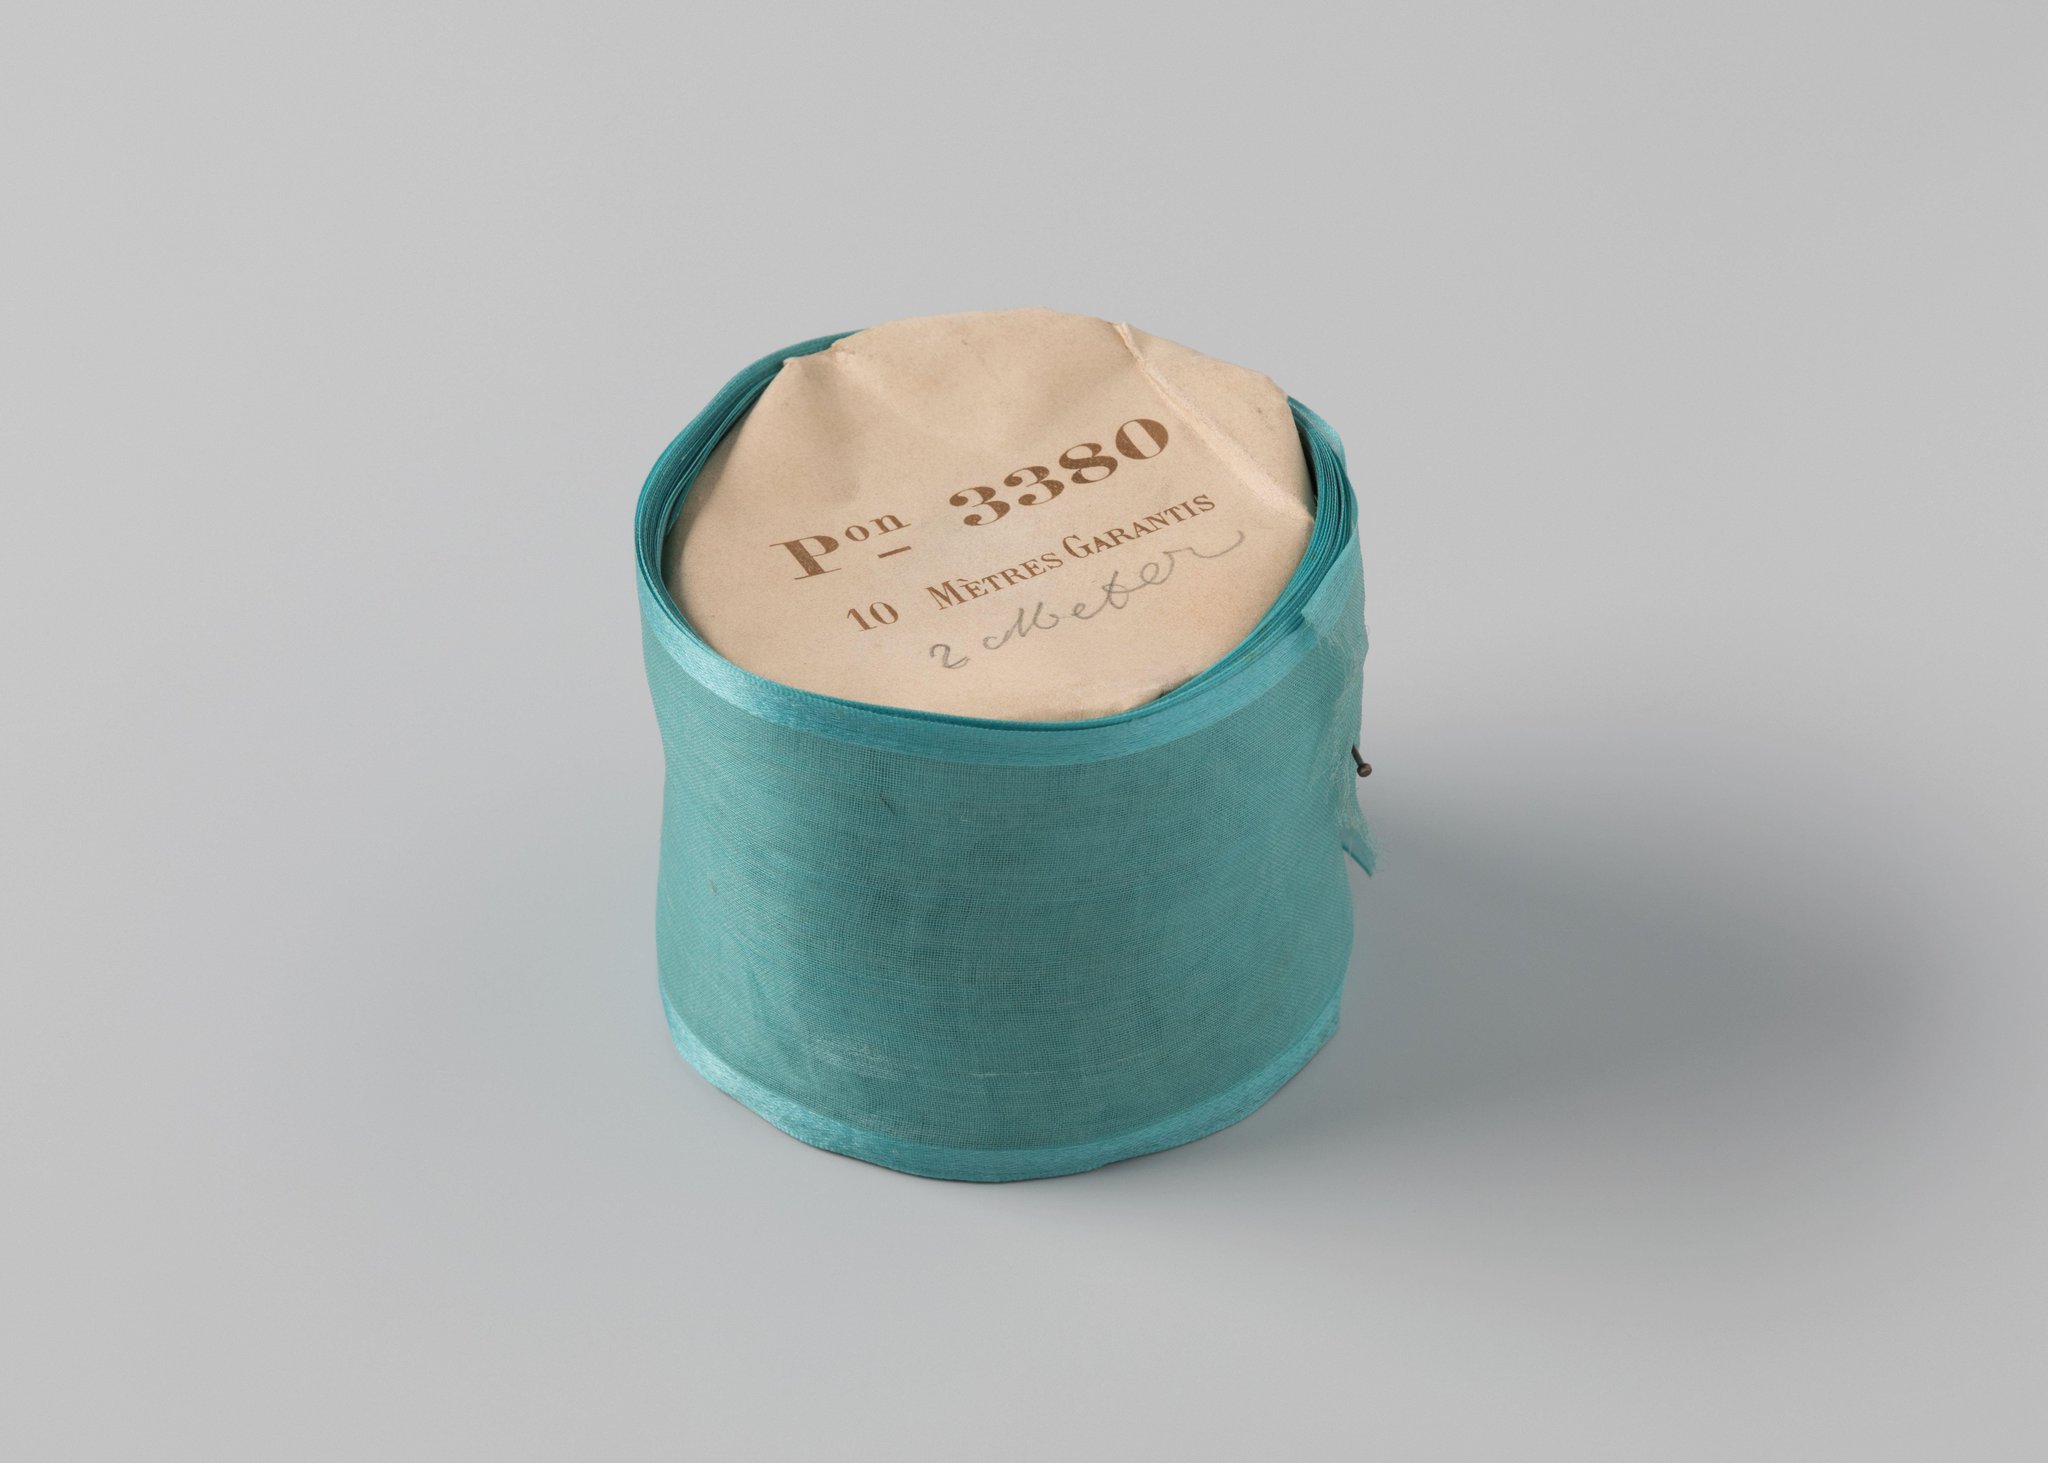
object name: ribbon material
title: Lint van turkoois gaas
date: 1900-1915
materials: textile, silk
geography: france